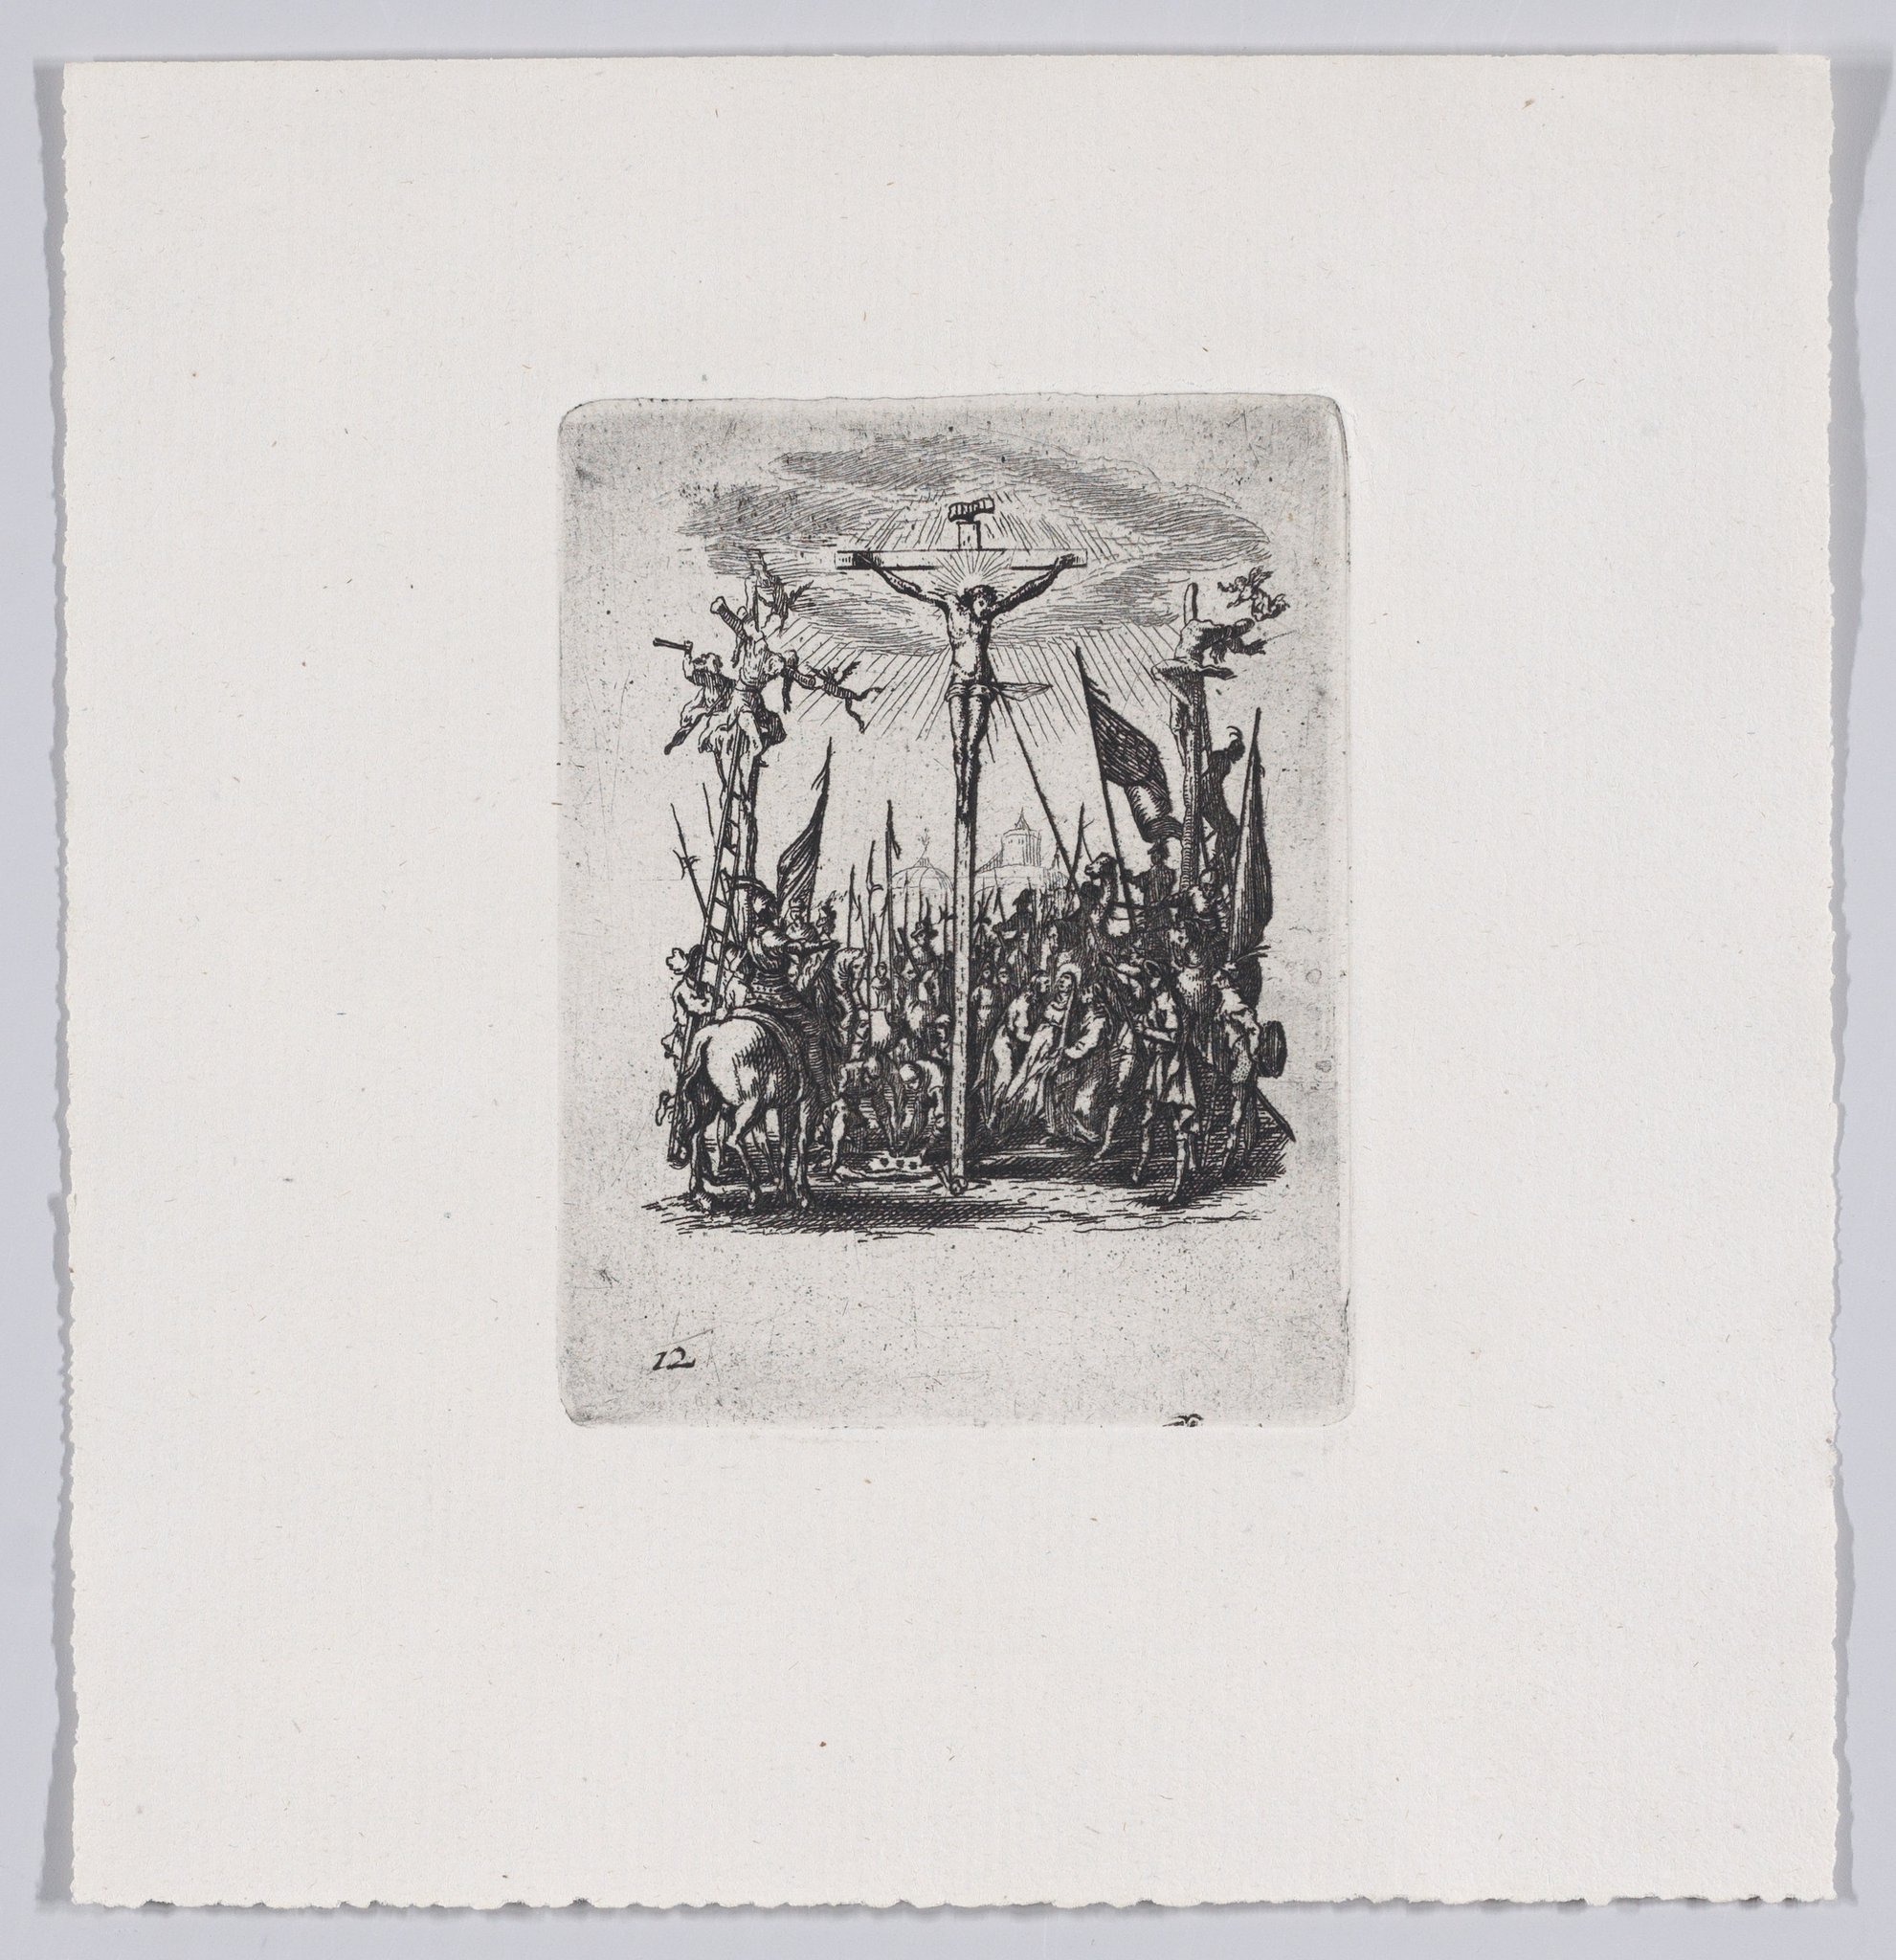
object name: print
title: Reverse Copy of Jésus est Percé d'une Lance (Jesus is Pierced with a Spear), from La Petite Passion (The Little Passion)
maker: Anonymous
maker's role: artist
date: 1601-1700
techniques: etching